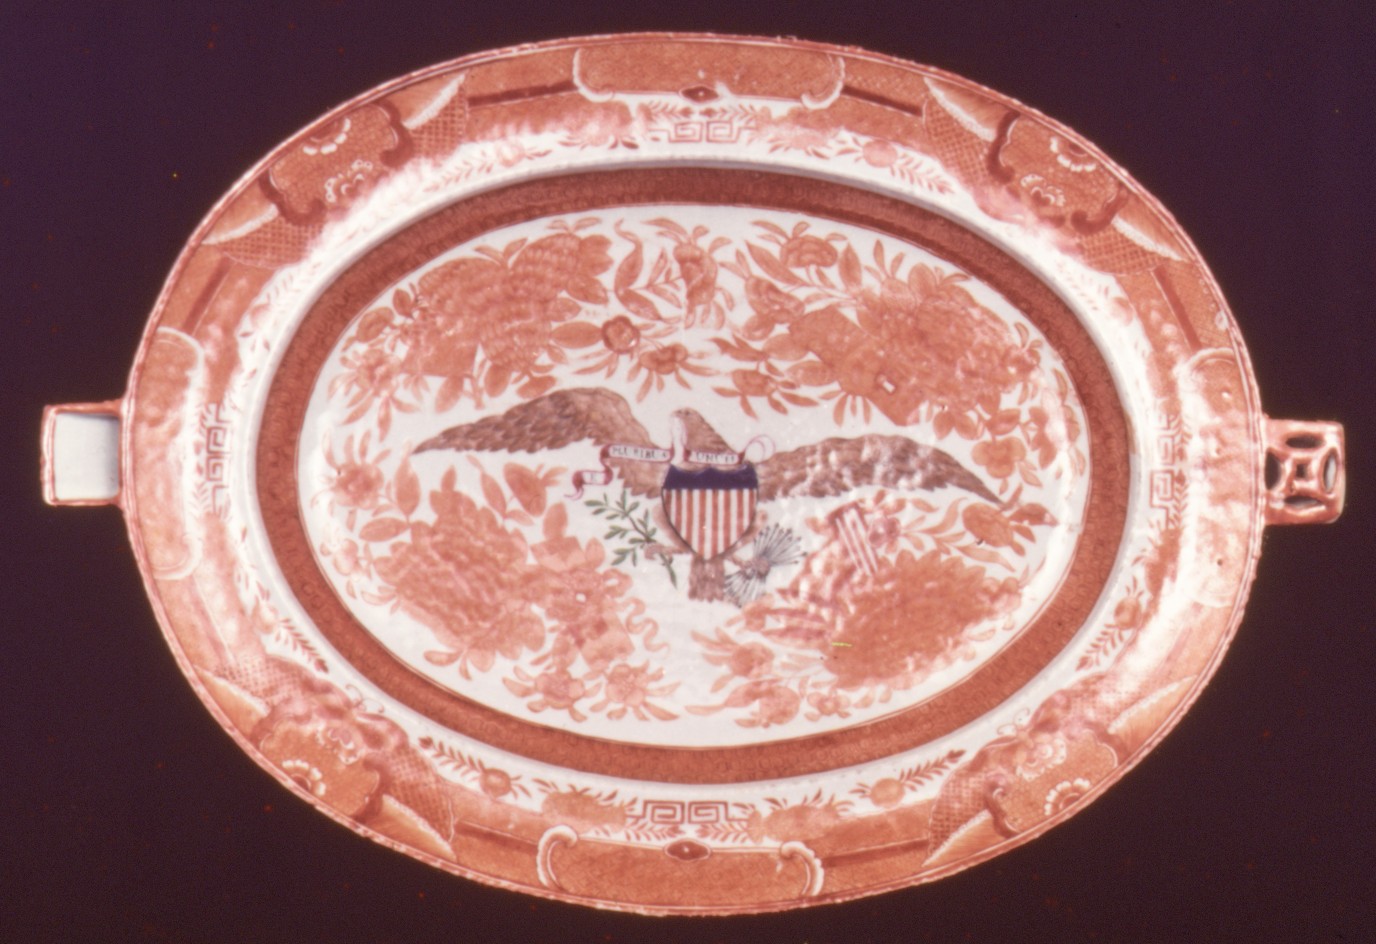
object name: hot water platter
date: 1801-1833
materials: hard paste porcelain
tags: eagles,coat of arms